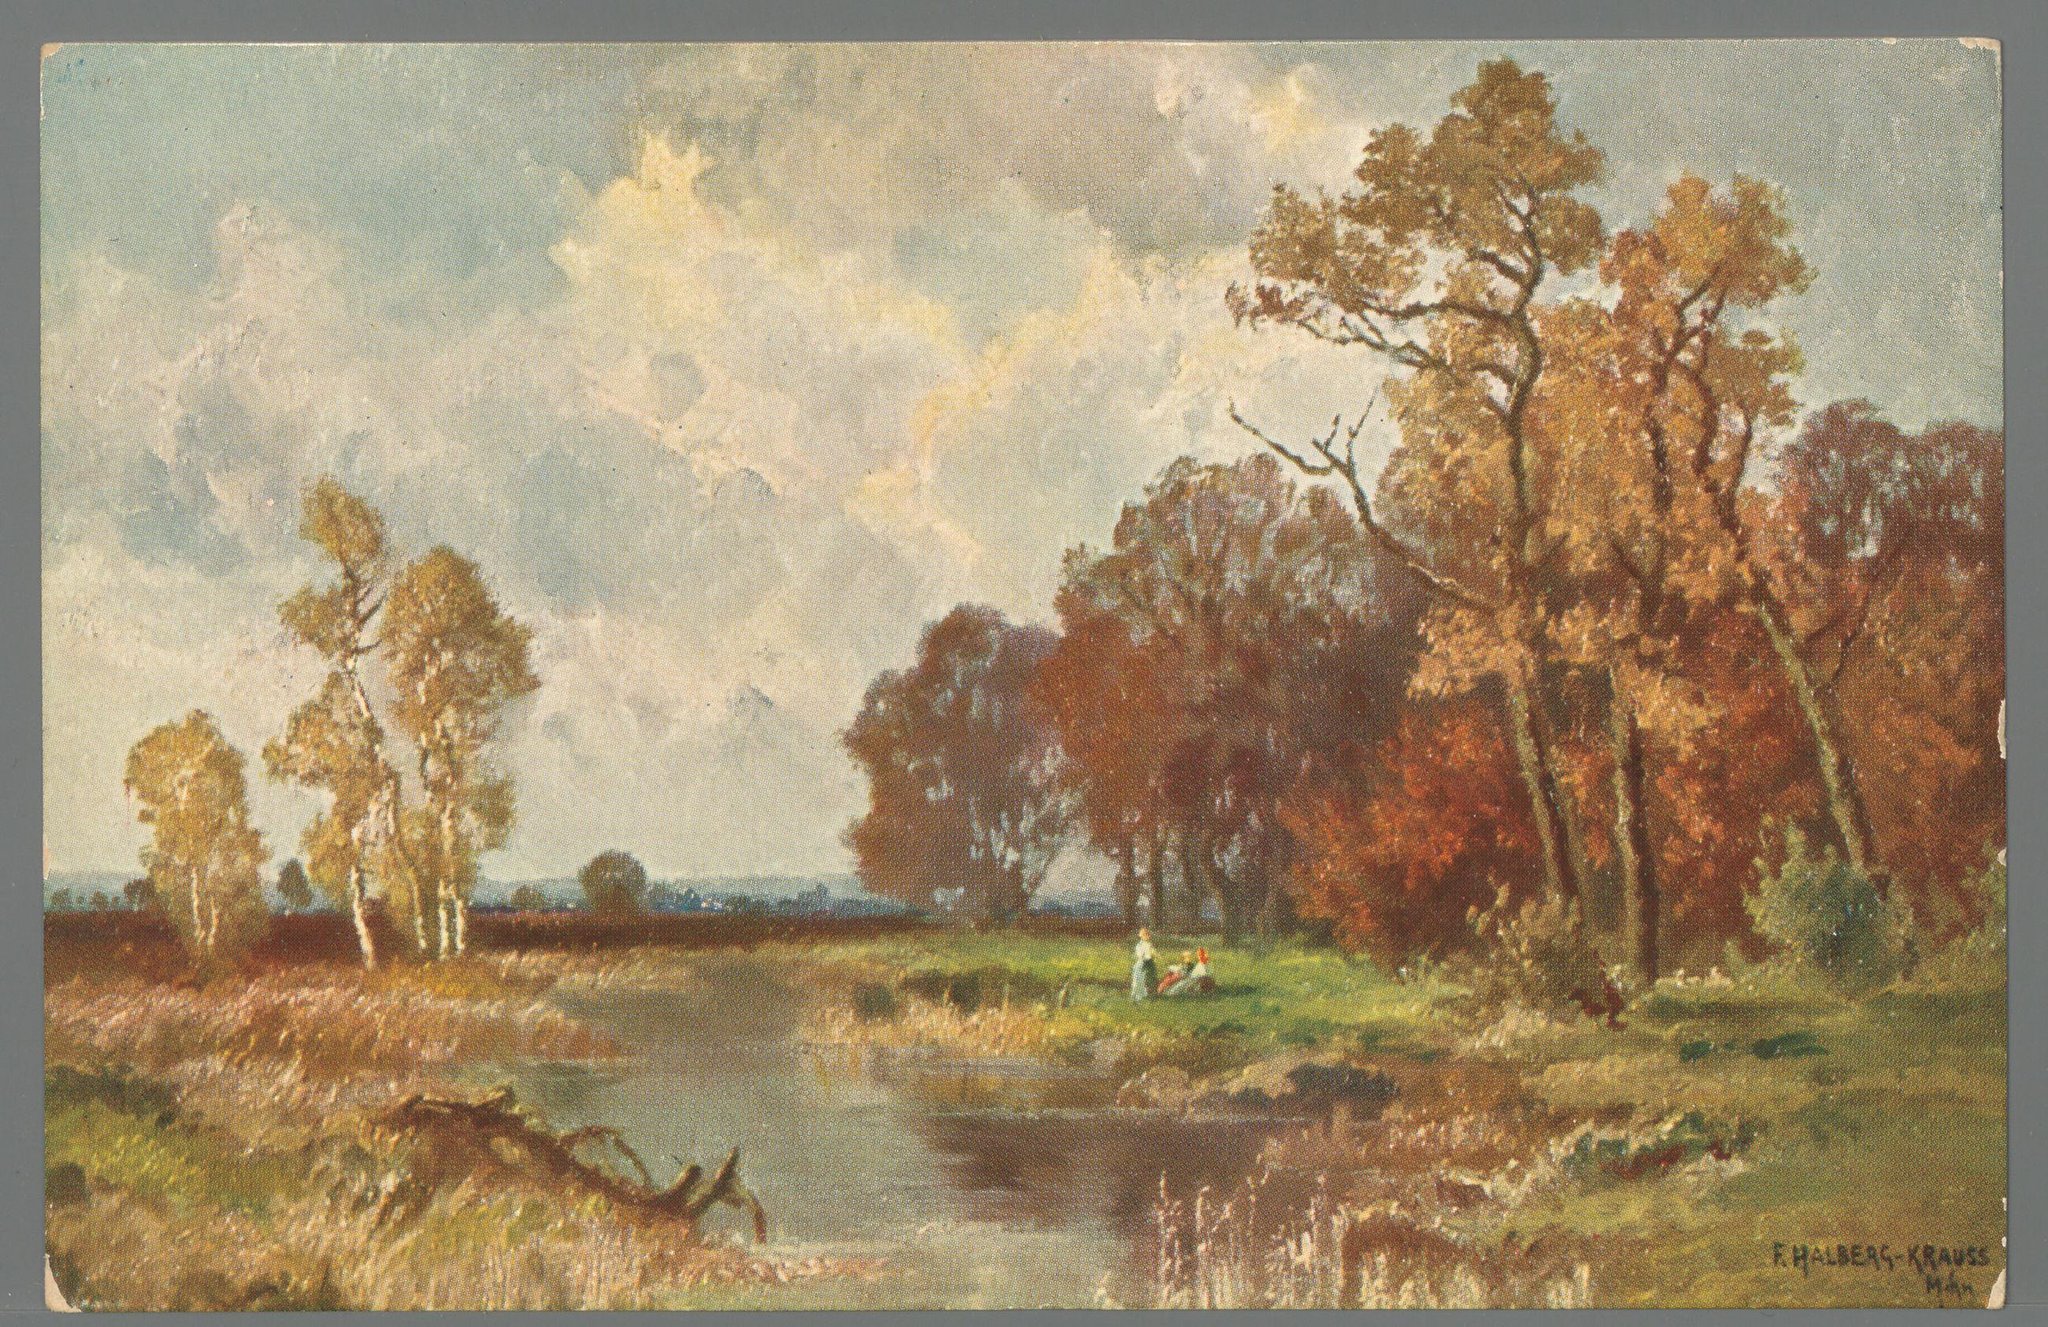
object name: reproduction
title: Freisinger Moos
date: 1905-1909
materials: cardboard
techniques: four-color autotype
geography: munich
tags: landscapes in the temperate zone (+ landscape with figures, staffage), plain